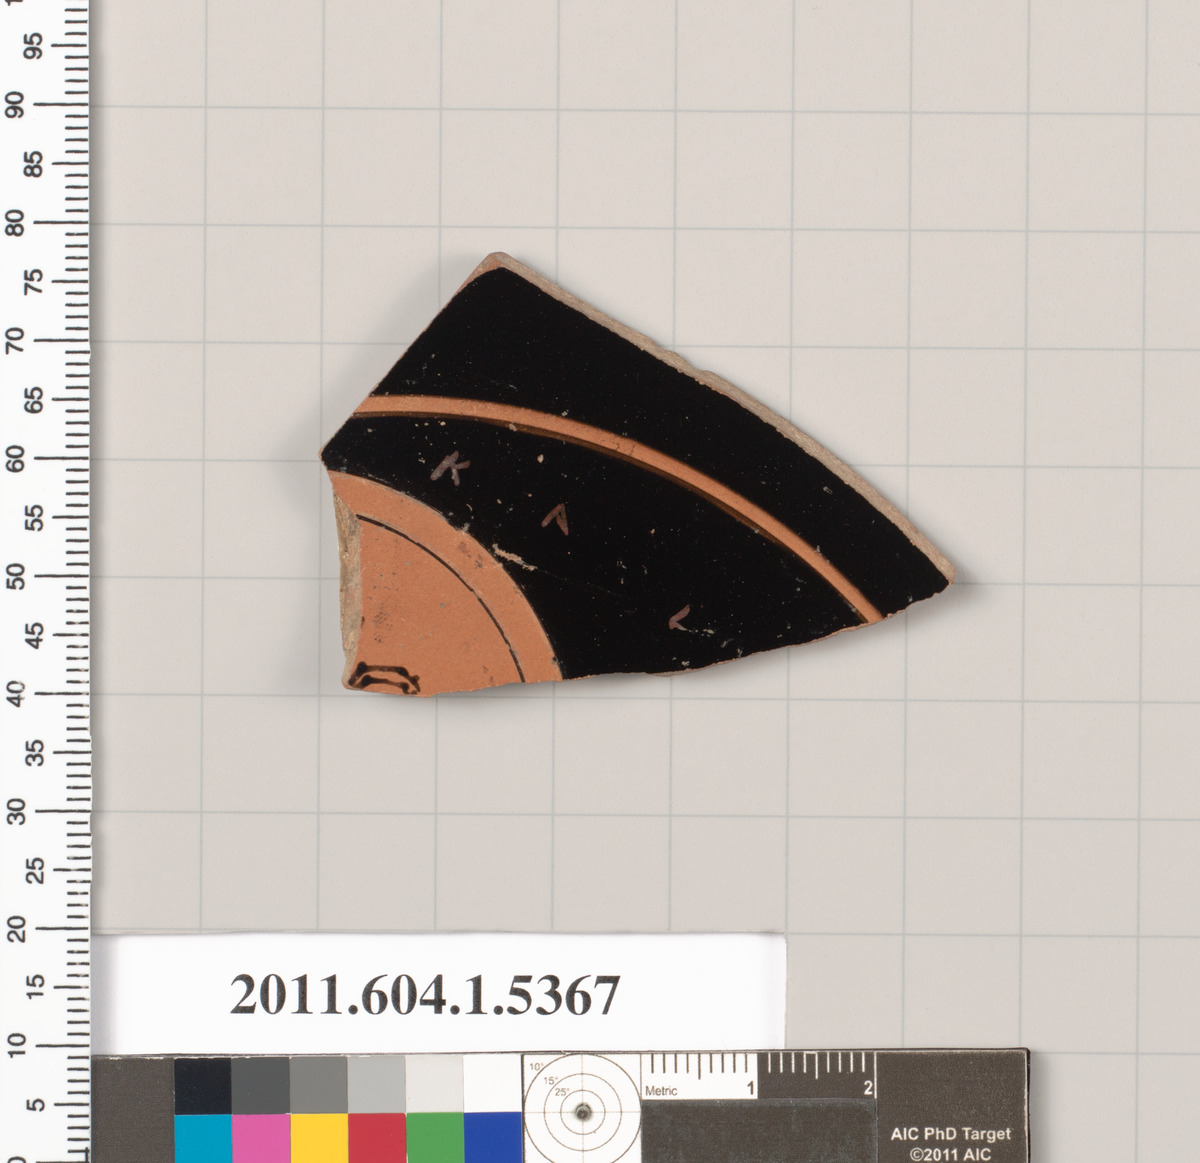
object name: kylix fragment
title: Terracotta fragment of a kylix (drinking cup)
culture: greek, attic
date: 510-490 BCE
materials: terracotta